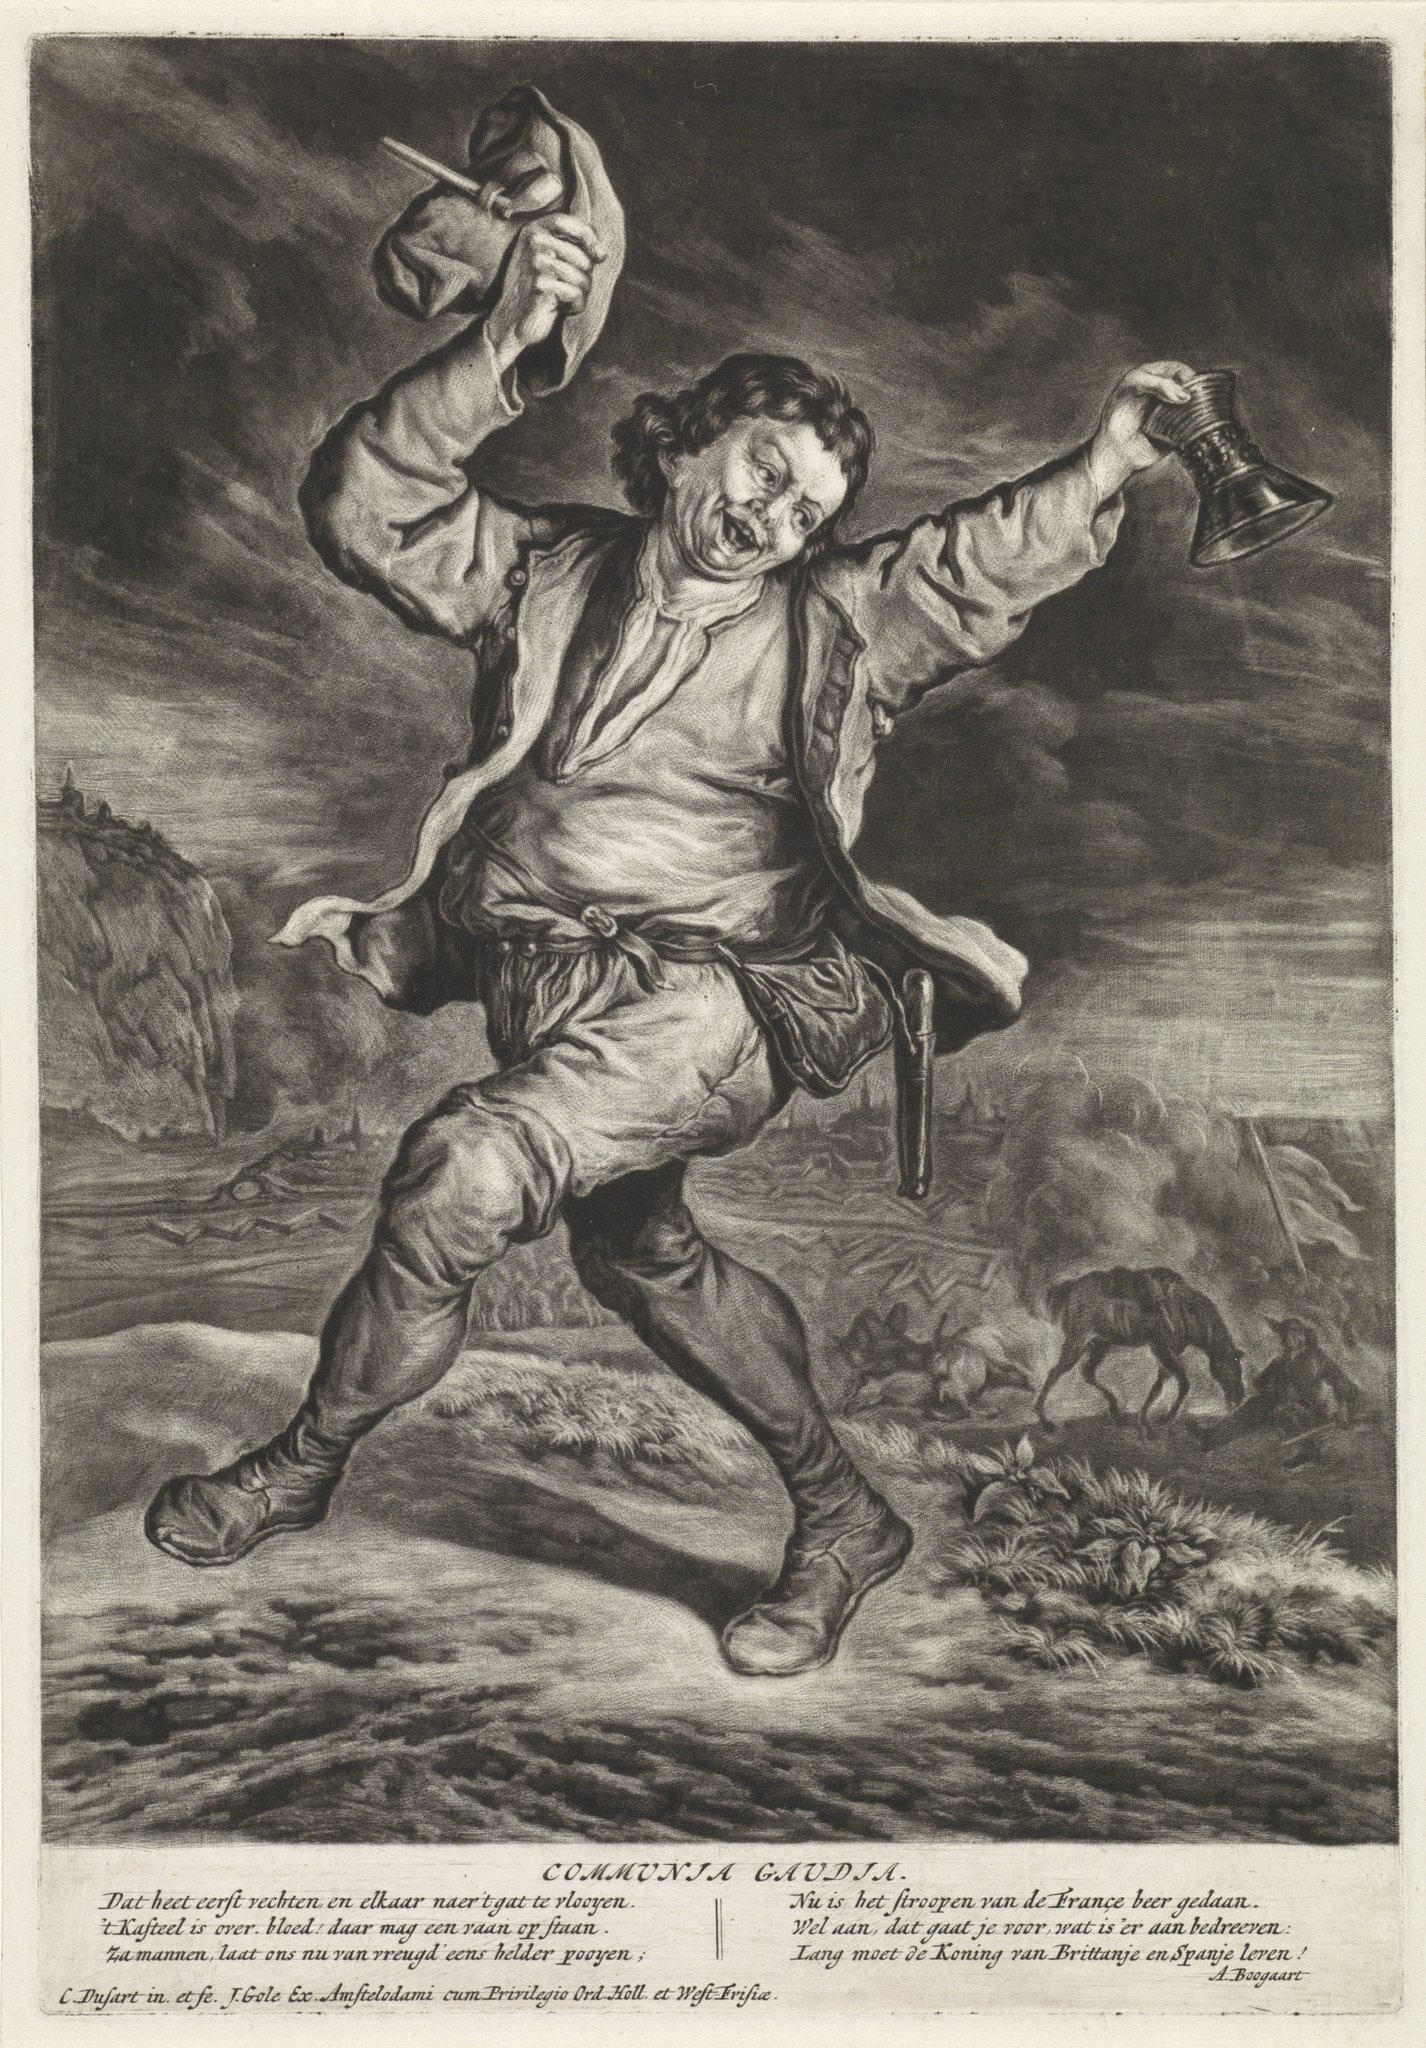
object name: print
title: De algemene blijdschap om de inname van Namen door stadhouder Willem III, koning van Engeland, september 1695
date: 1695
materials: paper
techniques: engraving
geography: amsterdam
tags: the hague, william iii (prince of orange and king of england, scotland, and ireland), festivities on events of national importance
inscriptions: collector's mark: Lugt 240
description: Dansende man met een lege roemer en zijn hoed in zijn hand. Op de achtergrond de stad Namen en de vesting. Onder de voorstelling een Latijnse titel en een Nederlands vers van zes regels. De prent is onderdeel van een reeks van acht prenten vervaardigd naar aanleiding van de verovering van Namen door de geallieerden op 5 september 1695.